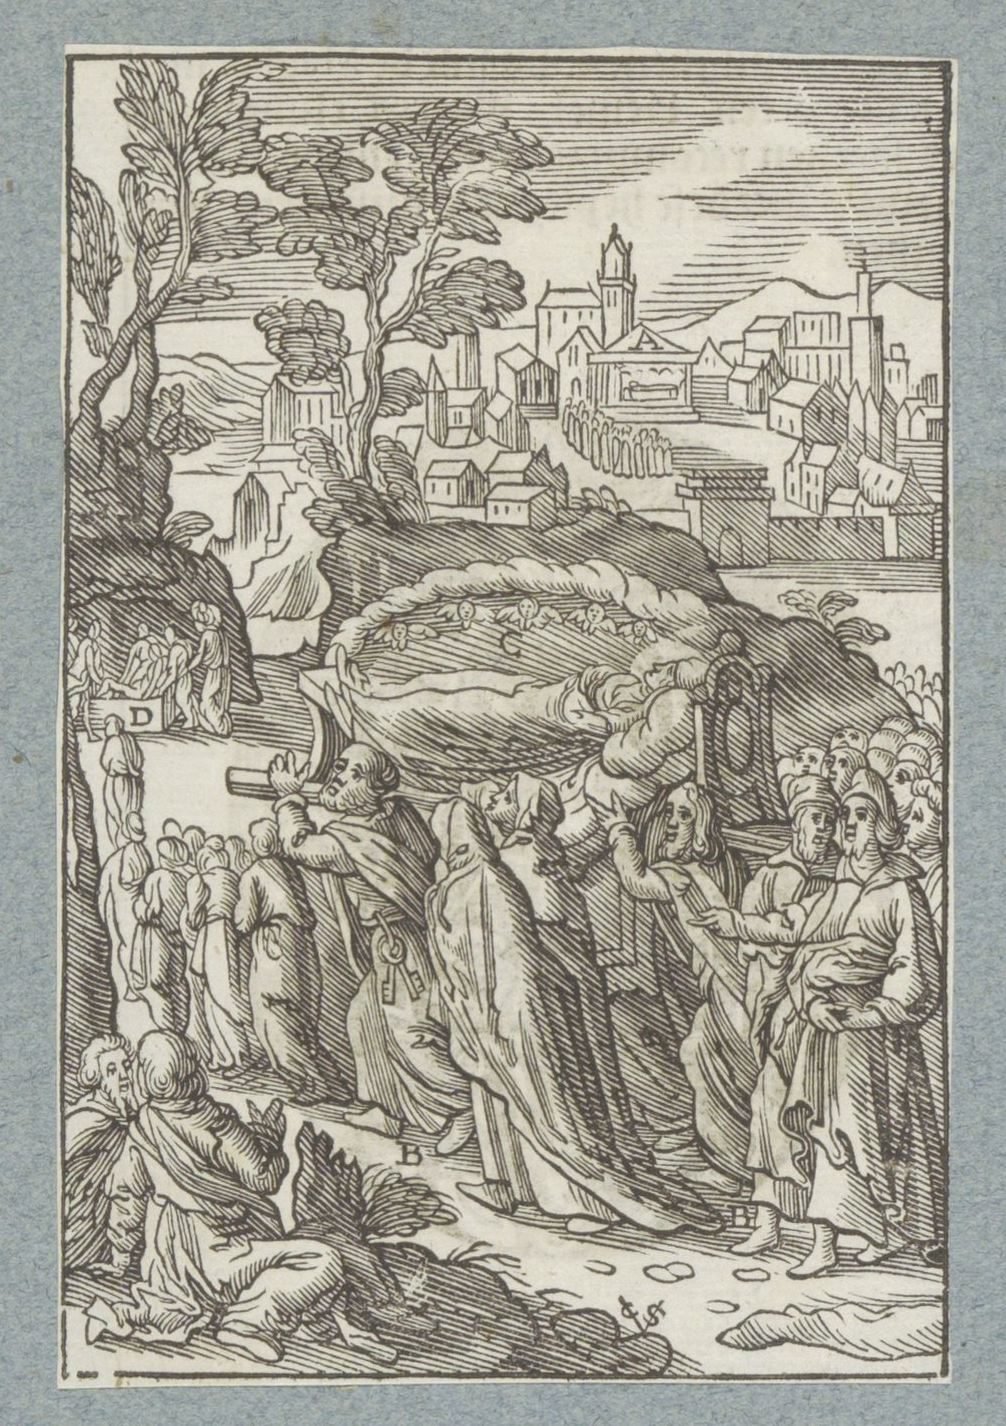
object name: album leaf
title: Begrafenis van Maria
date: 1629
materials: paper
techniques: letterpress printing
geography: antwerp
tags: the entombment of mary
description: De prent is afkomstig uit een van de uitgaven van P.J. Paets uit Amsterdam. De prent wordt voor het eerst gebruikt in: Der Zielen Lust-hof. Leuven, I.Jacbosz voor P.J. Paets [= Amsterdam, P.J. Paets], 1629. De voorstelling is gekopieerd naar een prent van Hieronymus Wierix voor: Nadal, Jerónimo. Evangelicae Historiae Imagines. Antwerpen, M. Nutius, 1593.